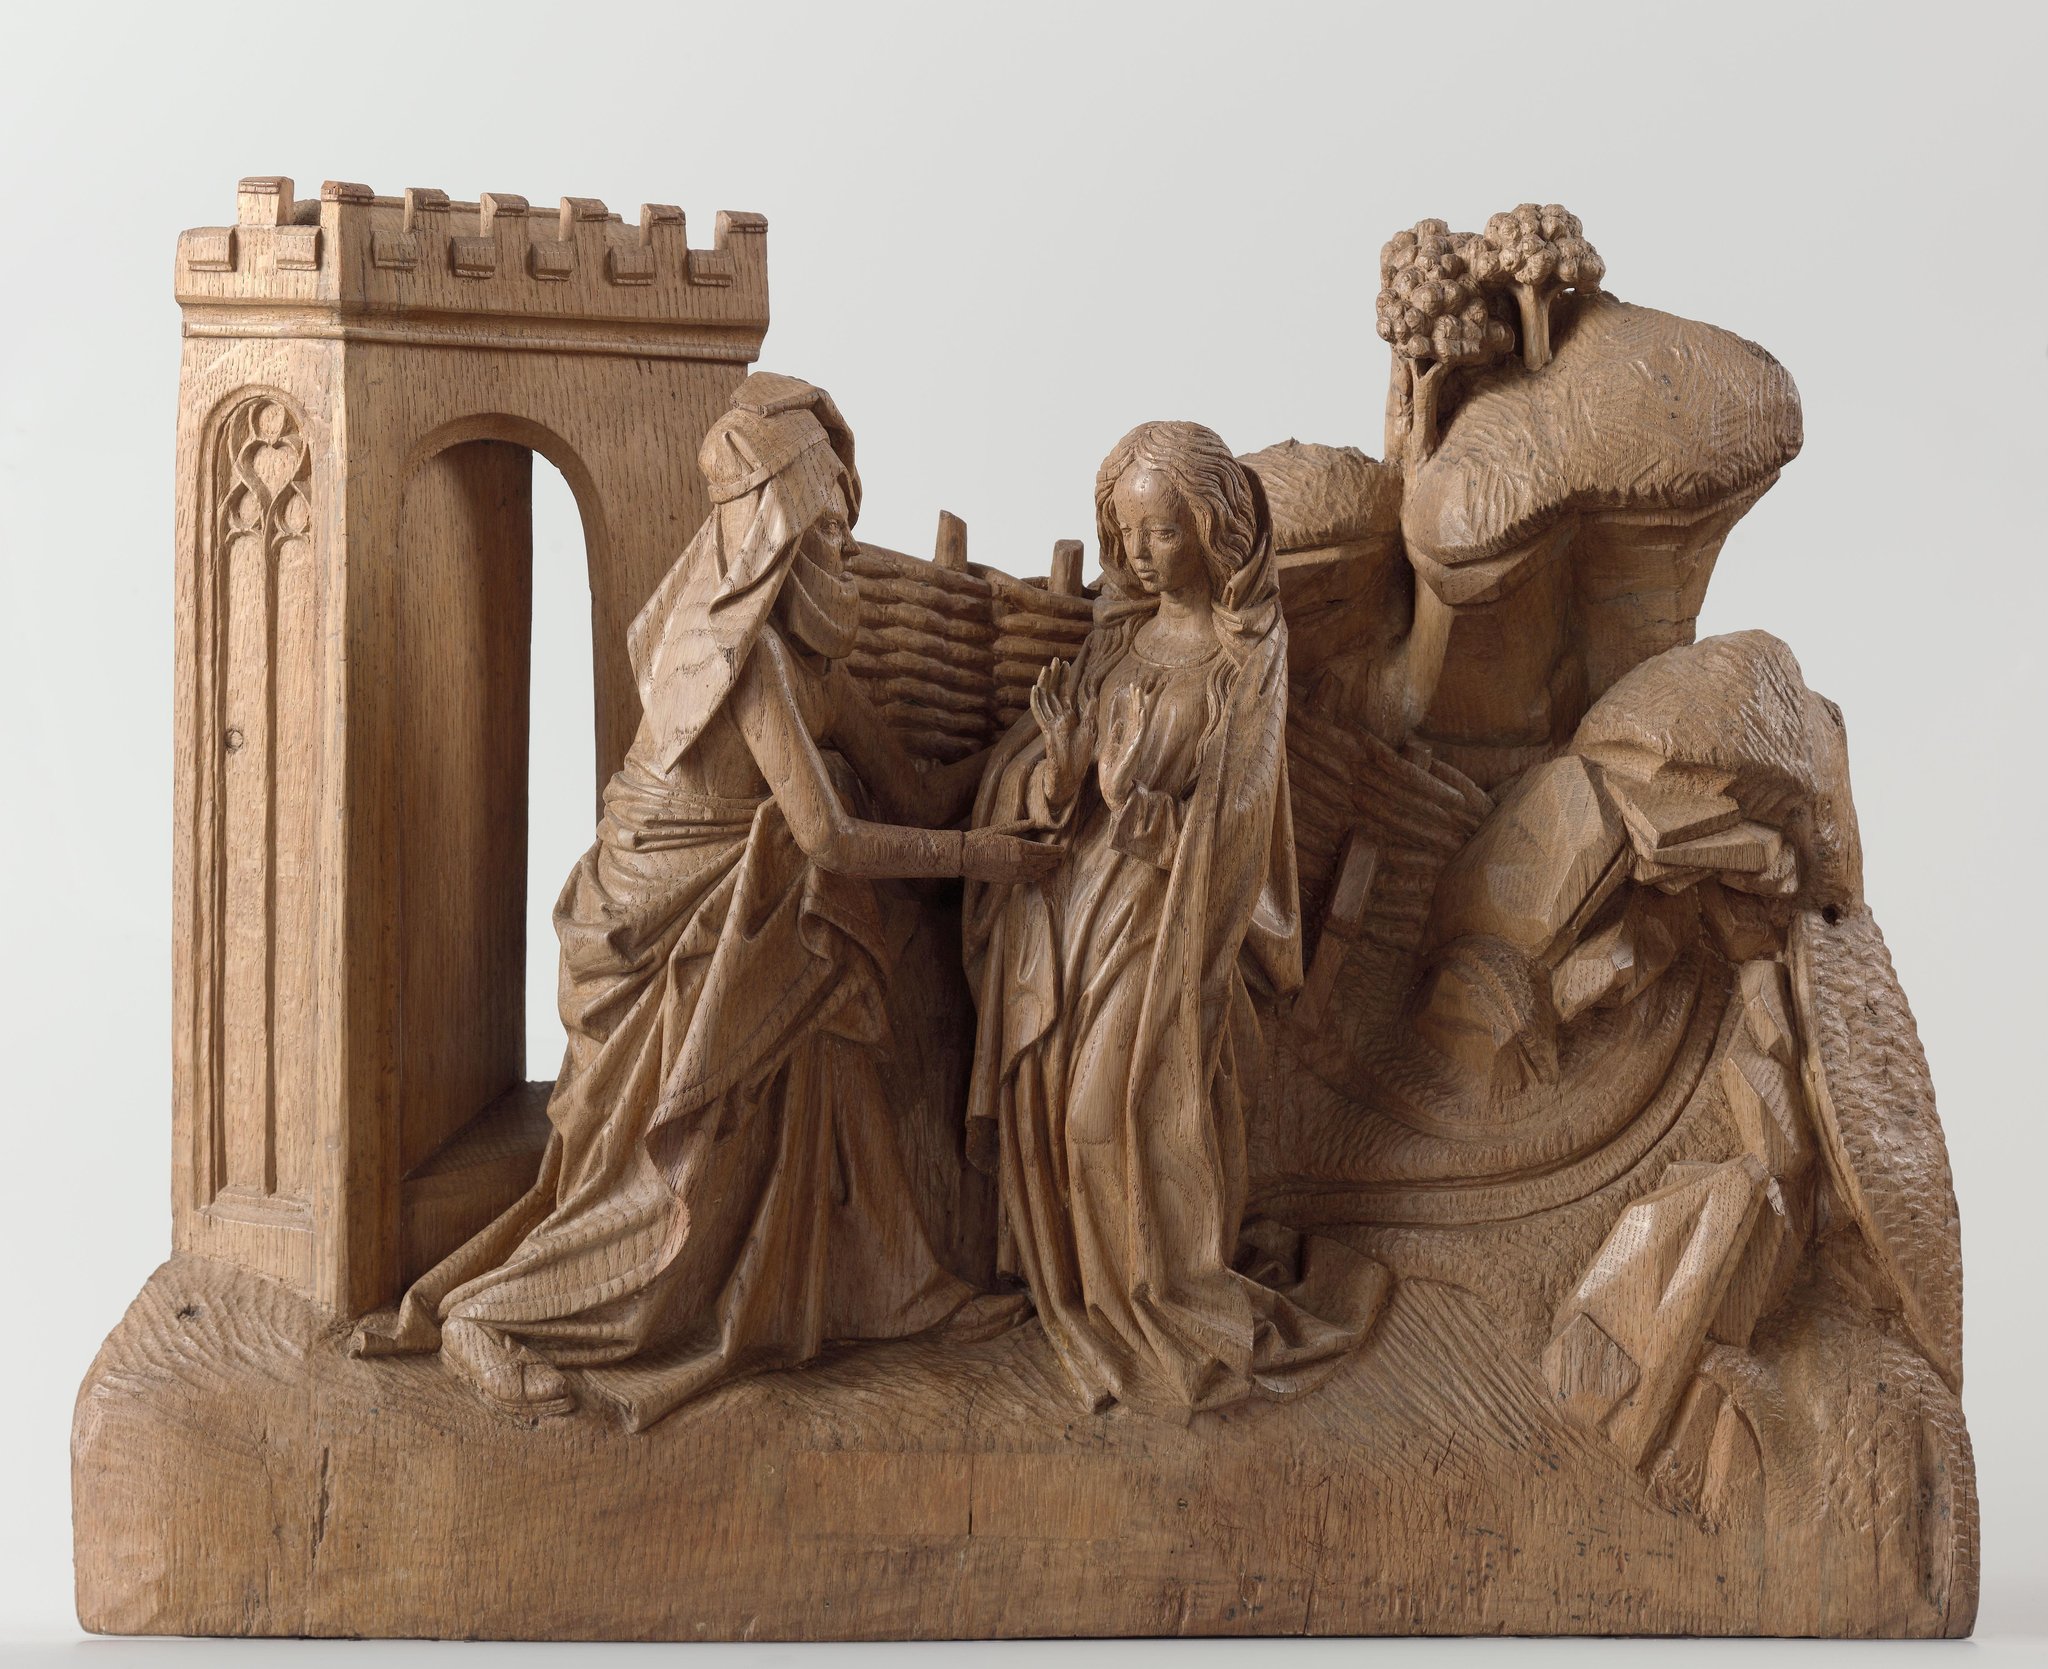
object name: sculpture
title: The Visitation, Fragment from the Marian Altar of the Illustrious Brotherhood of Our Blessed Lady in Den Bosch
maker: adriaen van wesel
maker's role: sculptor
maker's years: 1415-1490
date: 1475-1477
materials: wood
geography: utrecht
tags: mary and elisabeth, both pregnant, embracing, den bosch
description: These figures were part of a large altar in the chapel of the Confraternity of Our Lady in ‘s Hertogenbosch. This was a highly innovative altar, with its lively, expressive scenes and figures. Five fragments are arranged here in their original order. The adoration of the newborn Child (now missing) by the Virgin, Joseph and the angels was at the very centre of the altar.